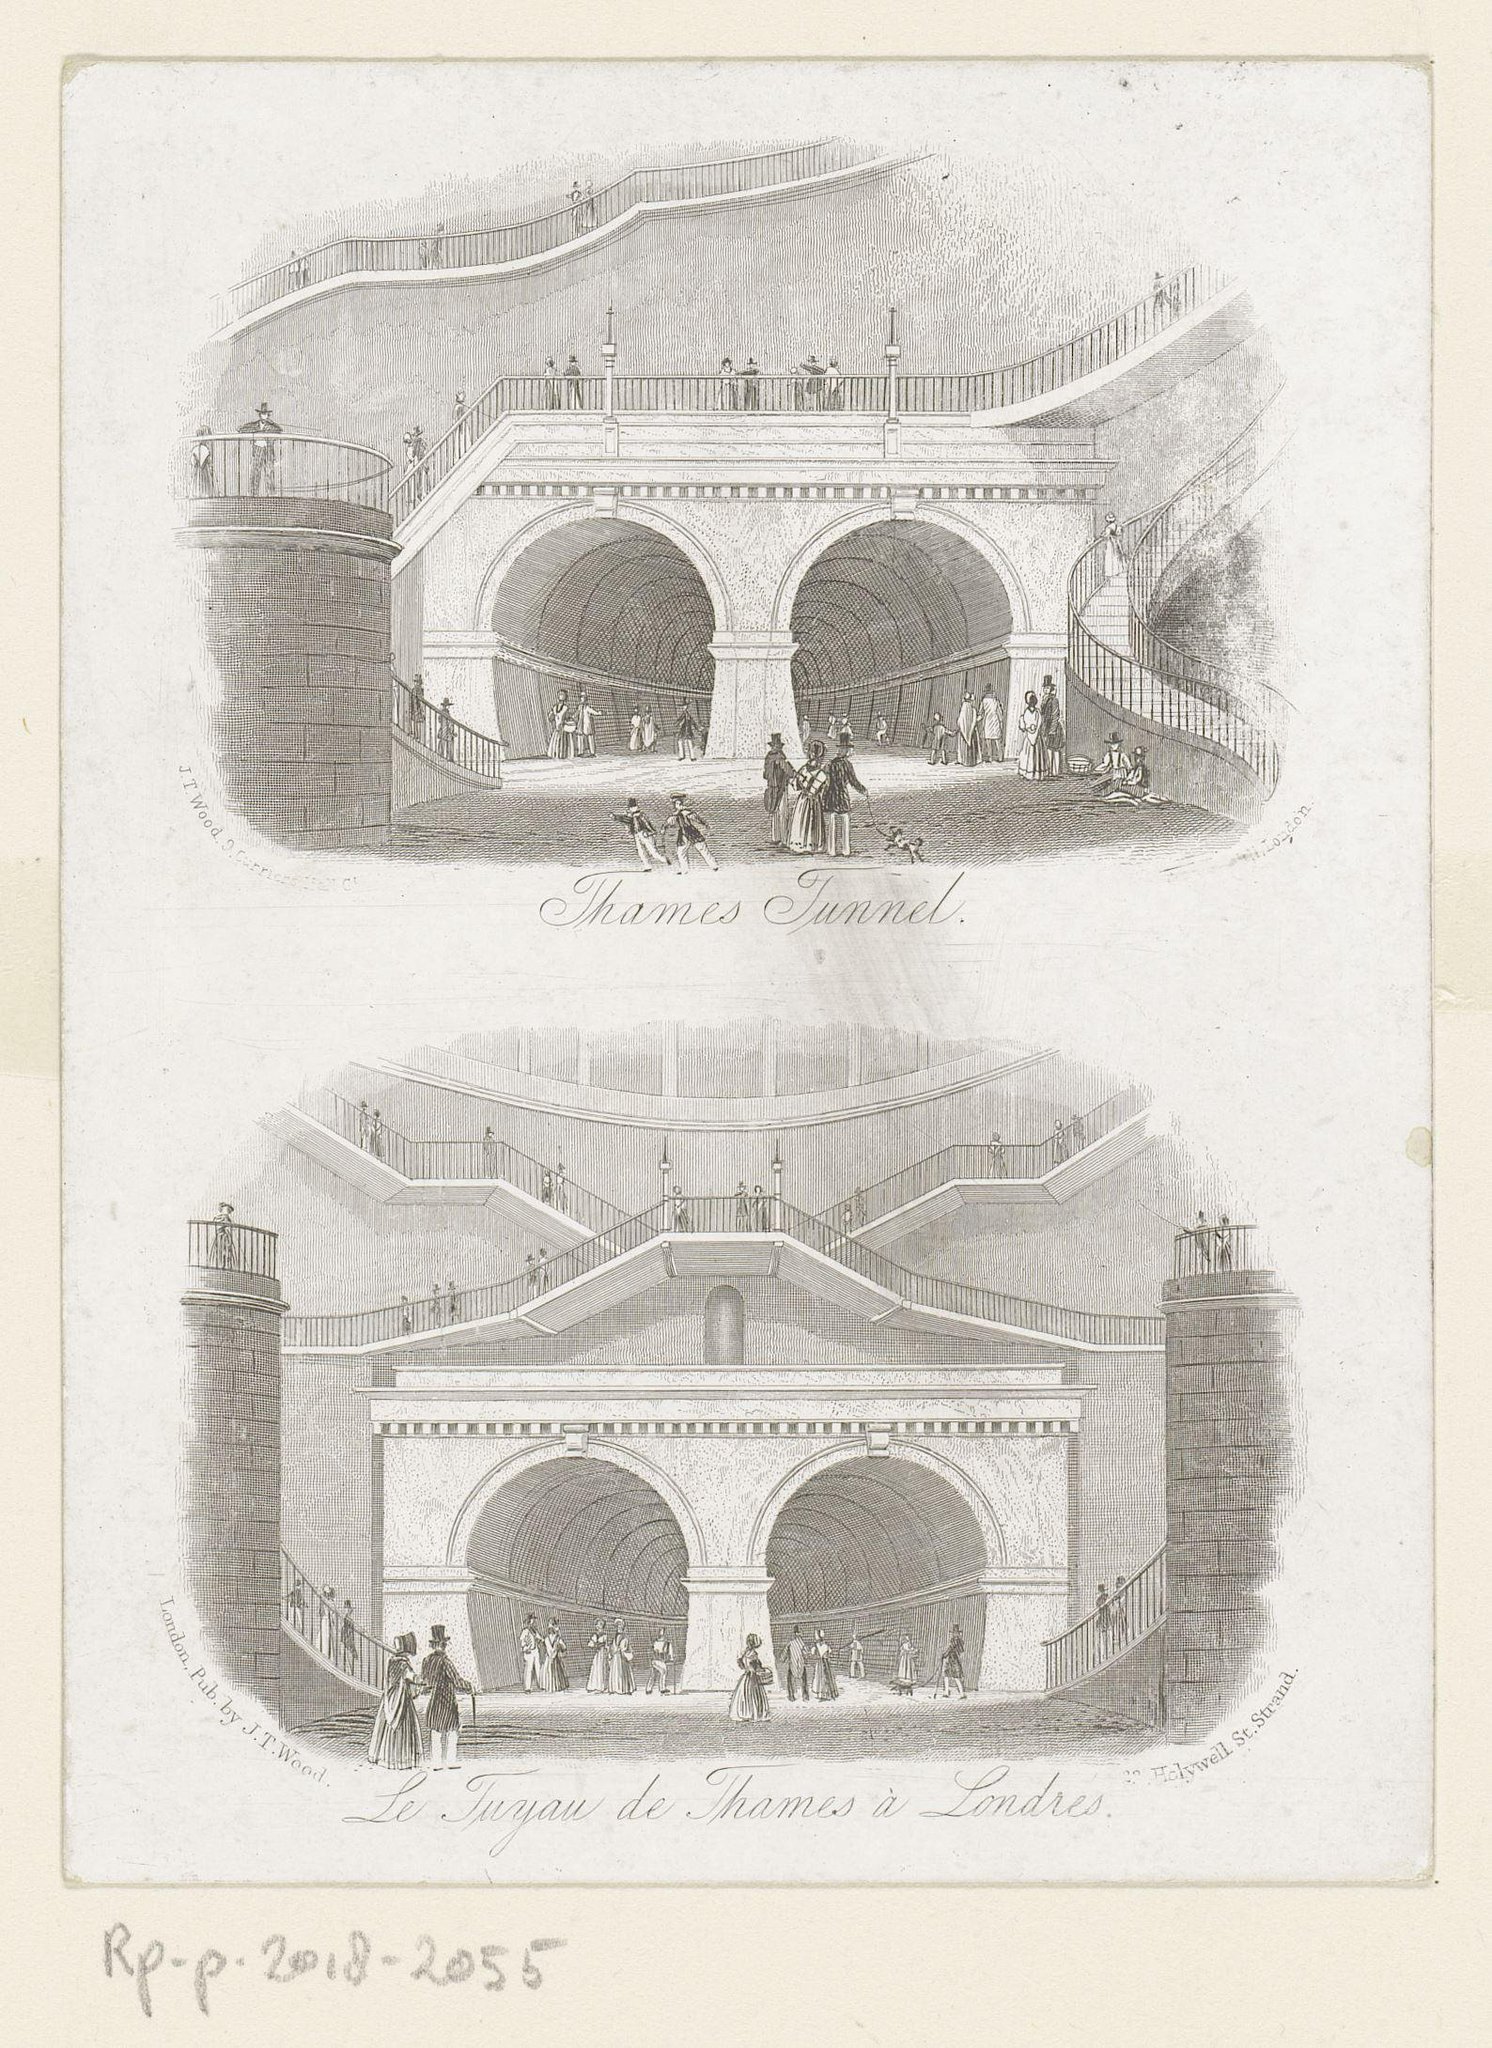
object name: print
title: Thames Tunnel / Le Tuyau de Thames à Londres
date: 1843-1885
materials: paper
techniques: etching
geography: london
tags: underground road, tunnel, london